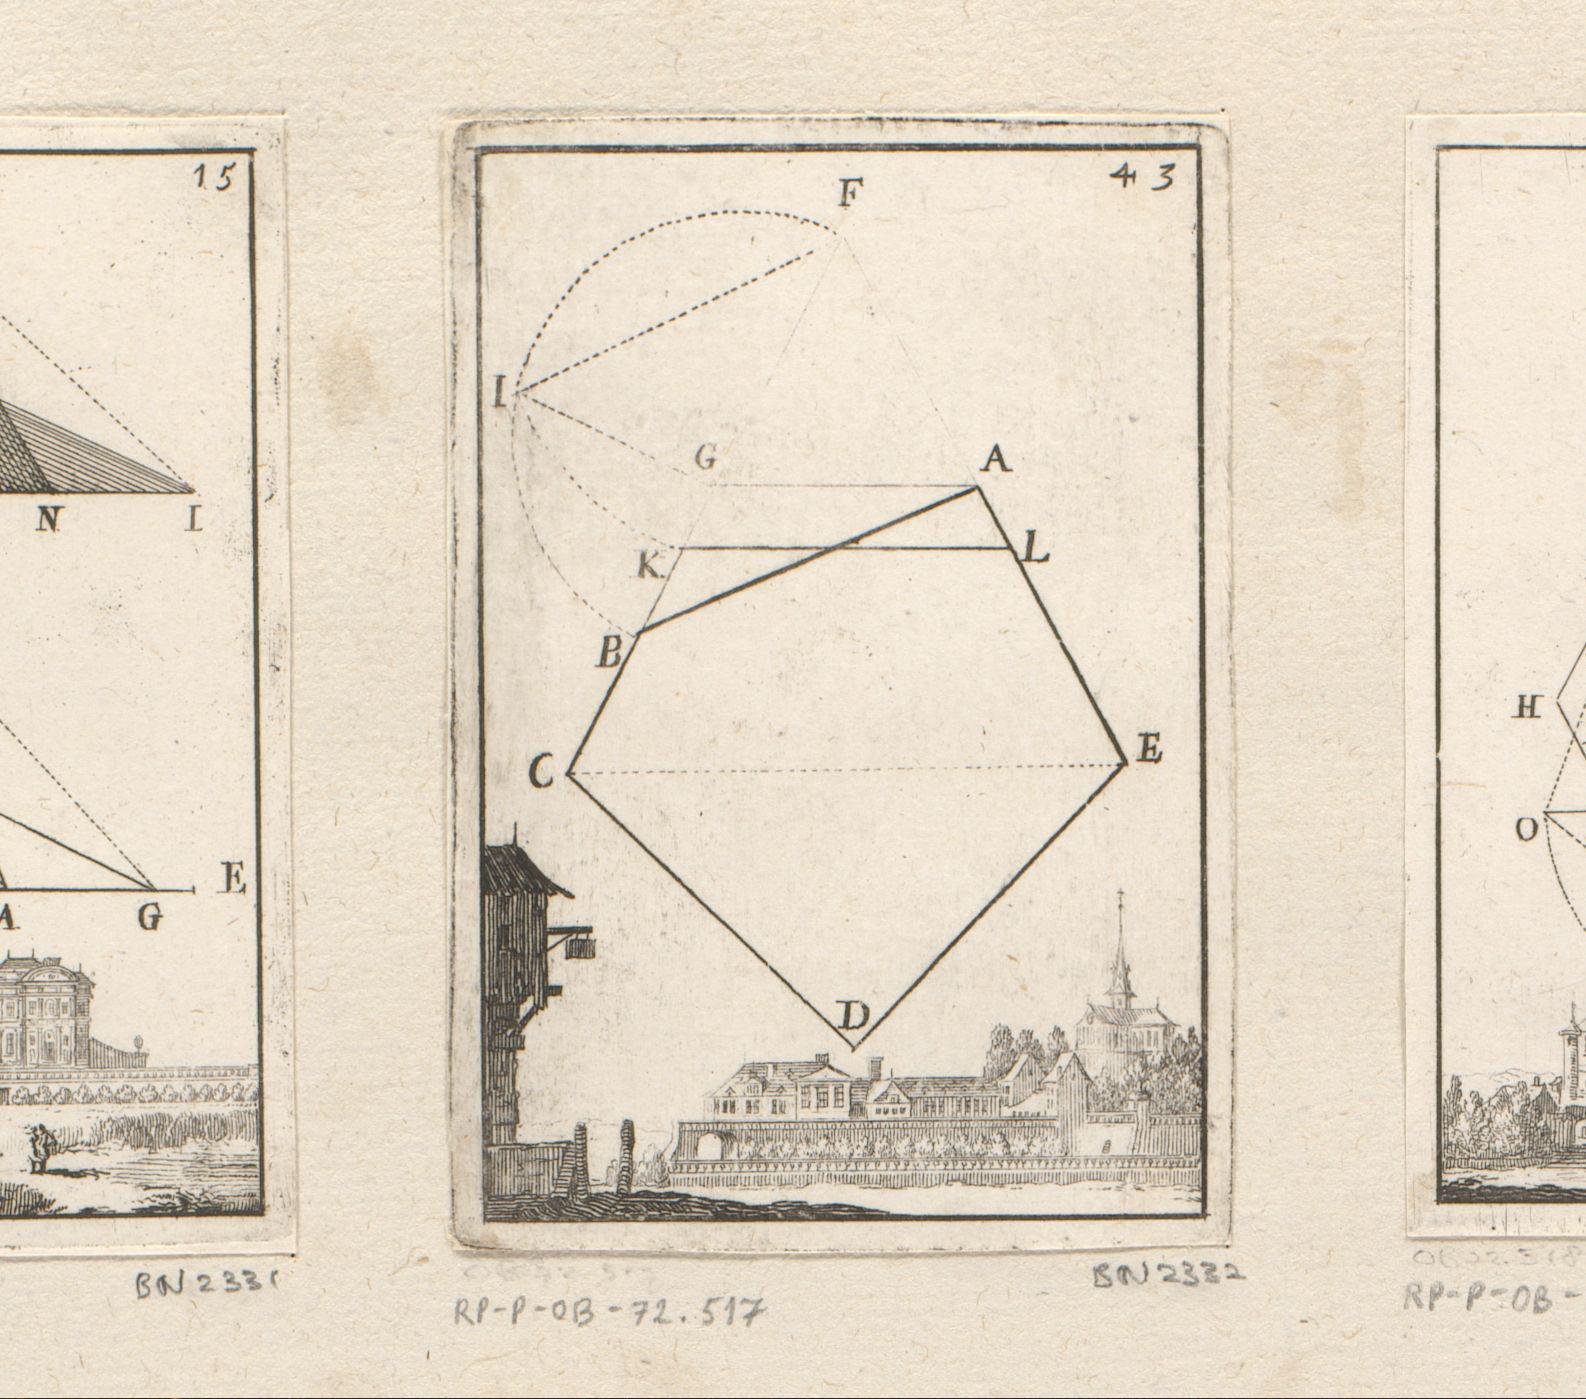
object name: book illustration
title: Parallelle zijden met onderaan zicht op een stad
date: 1669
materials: paper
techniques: etching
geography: paris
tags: city-view in general; 'veduta', planimetry, geometry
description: Prent toegevoegd aan: Pratique de la géometrie, sur le papier et sur le terrain. Avec un nouvel ordre et une méthode particulière. Parijs: Thomas Jolly, 1669.